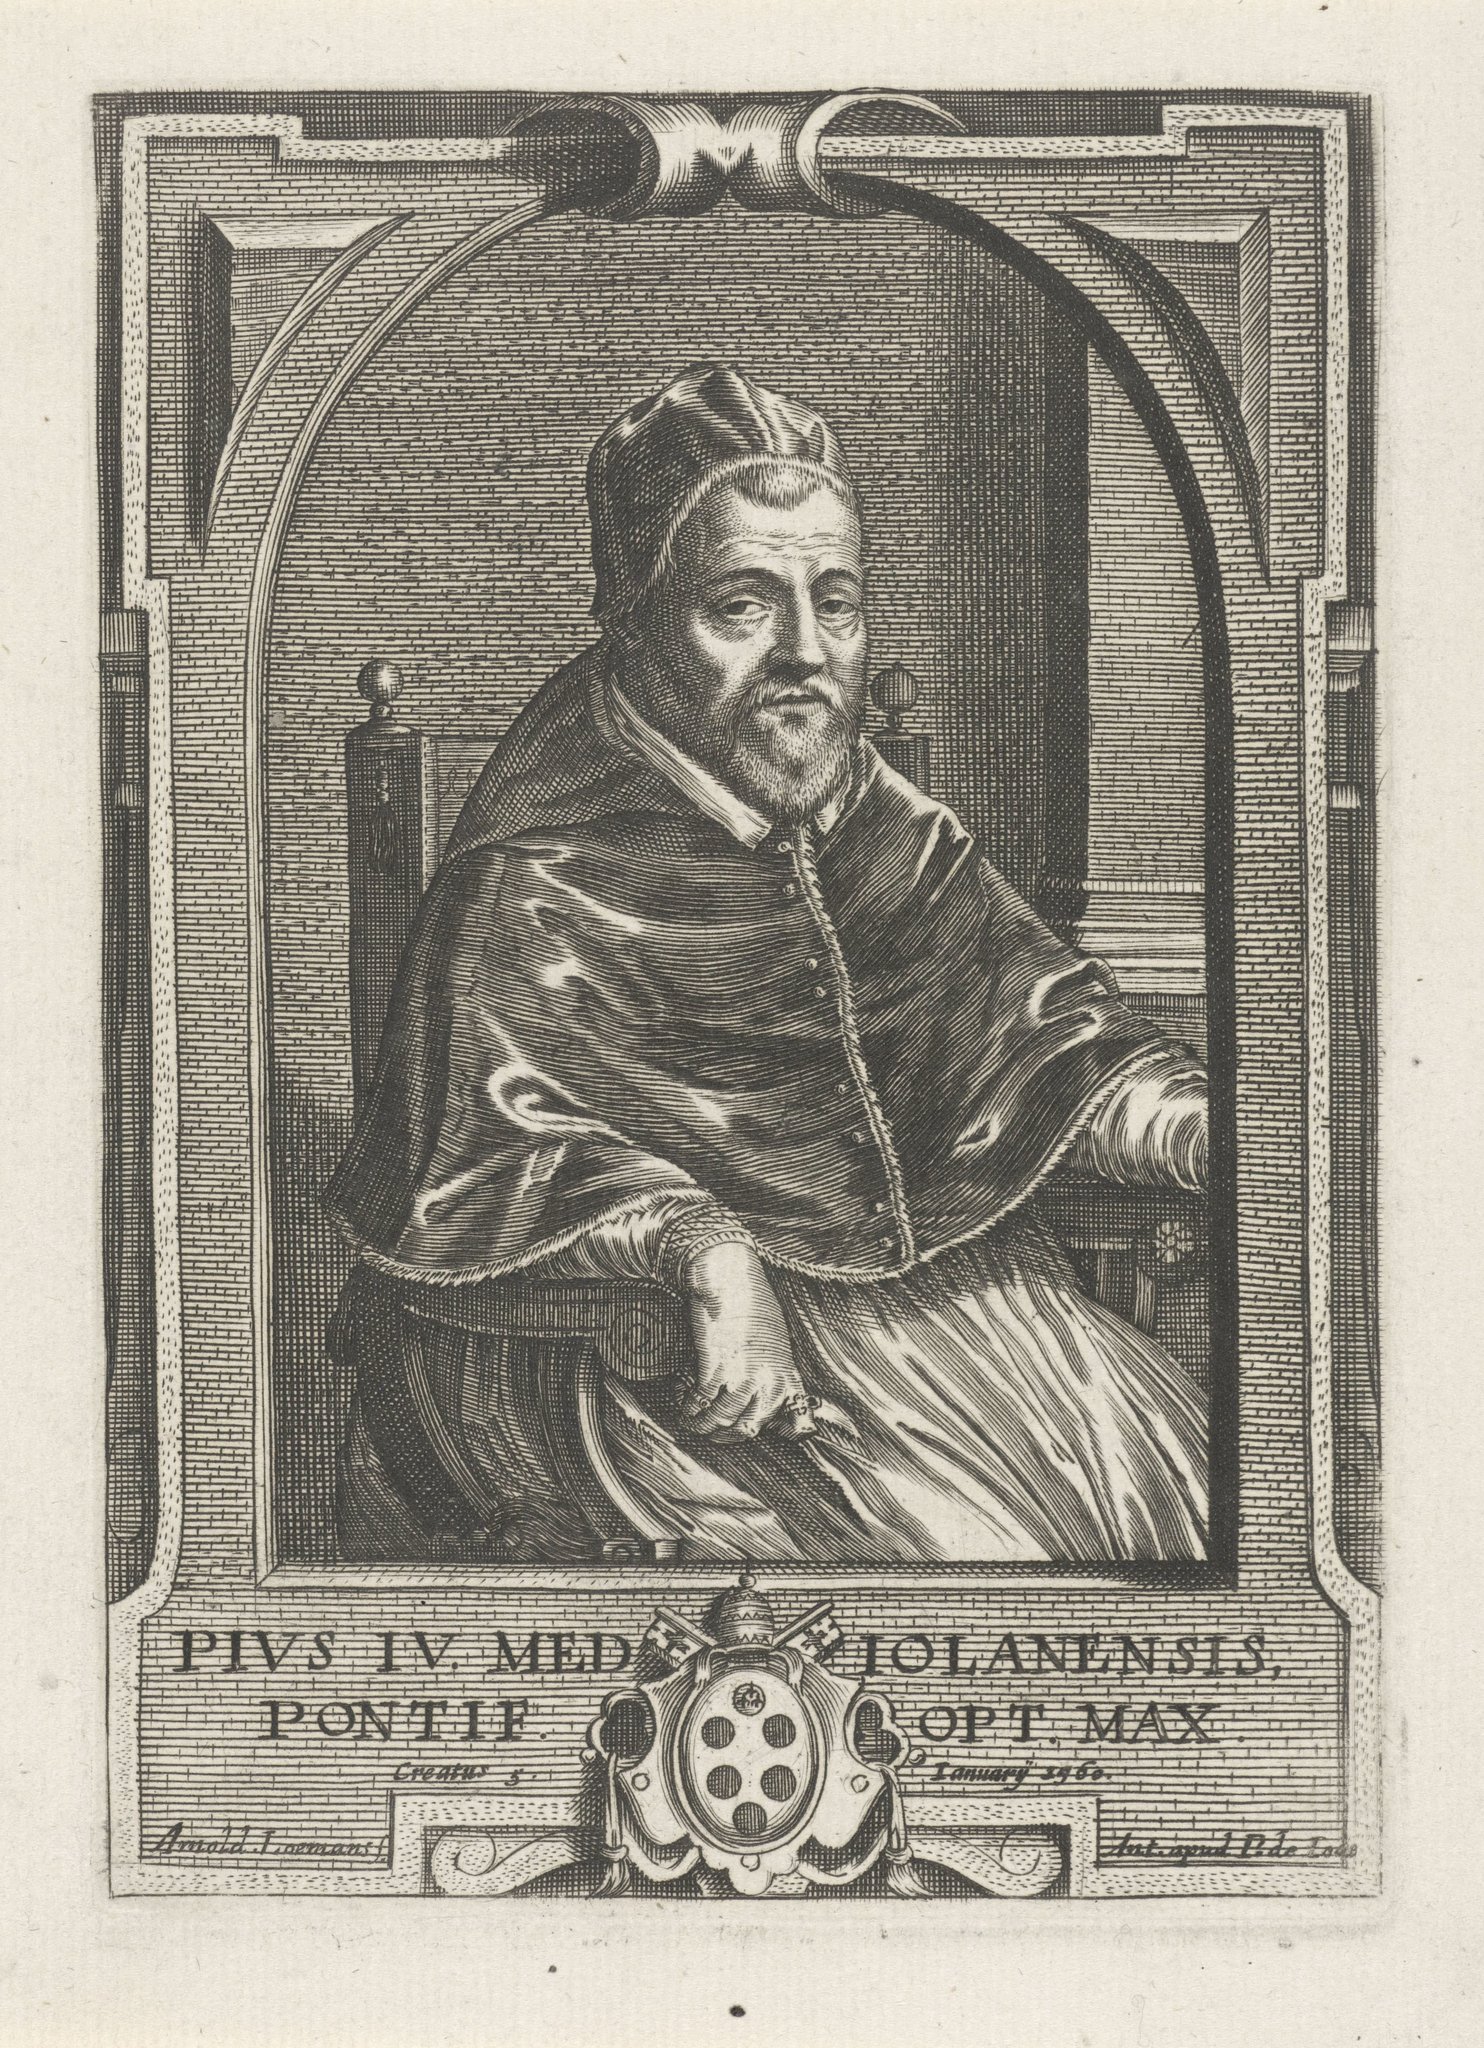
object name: print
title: Portret van paus Pius IV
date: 1632-1670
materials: paper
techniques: engraving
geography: antwerp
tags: rome, pius iv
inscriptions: collector's mark: Lugt 2228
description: Portret van paus Pius IV, met zijn pauselijk wapen.